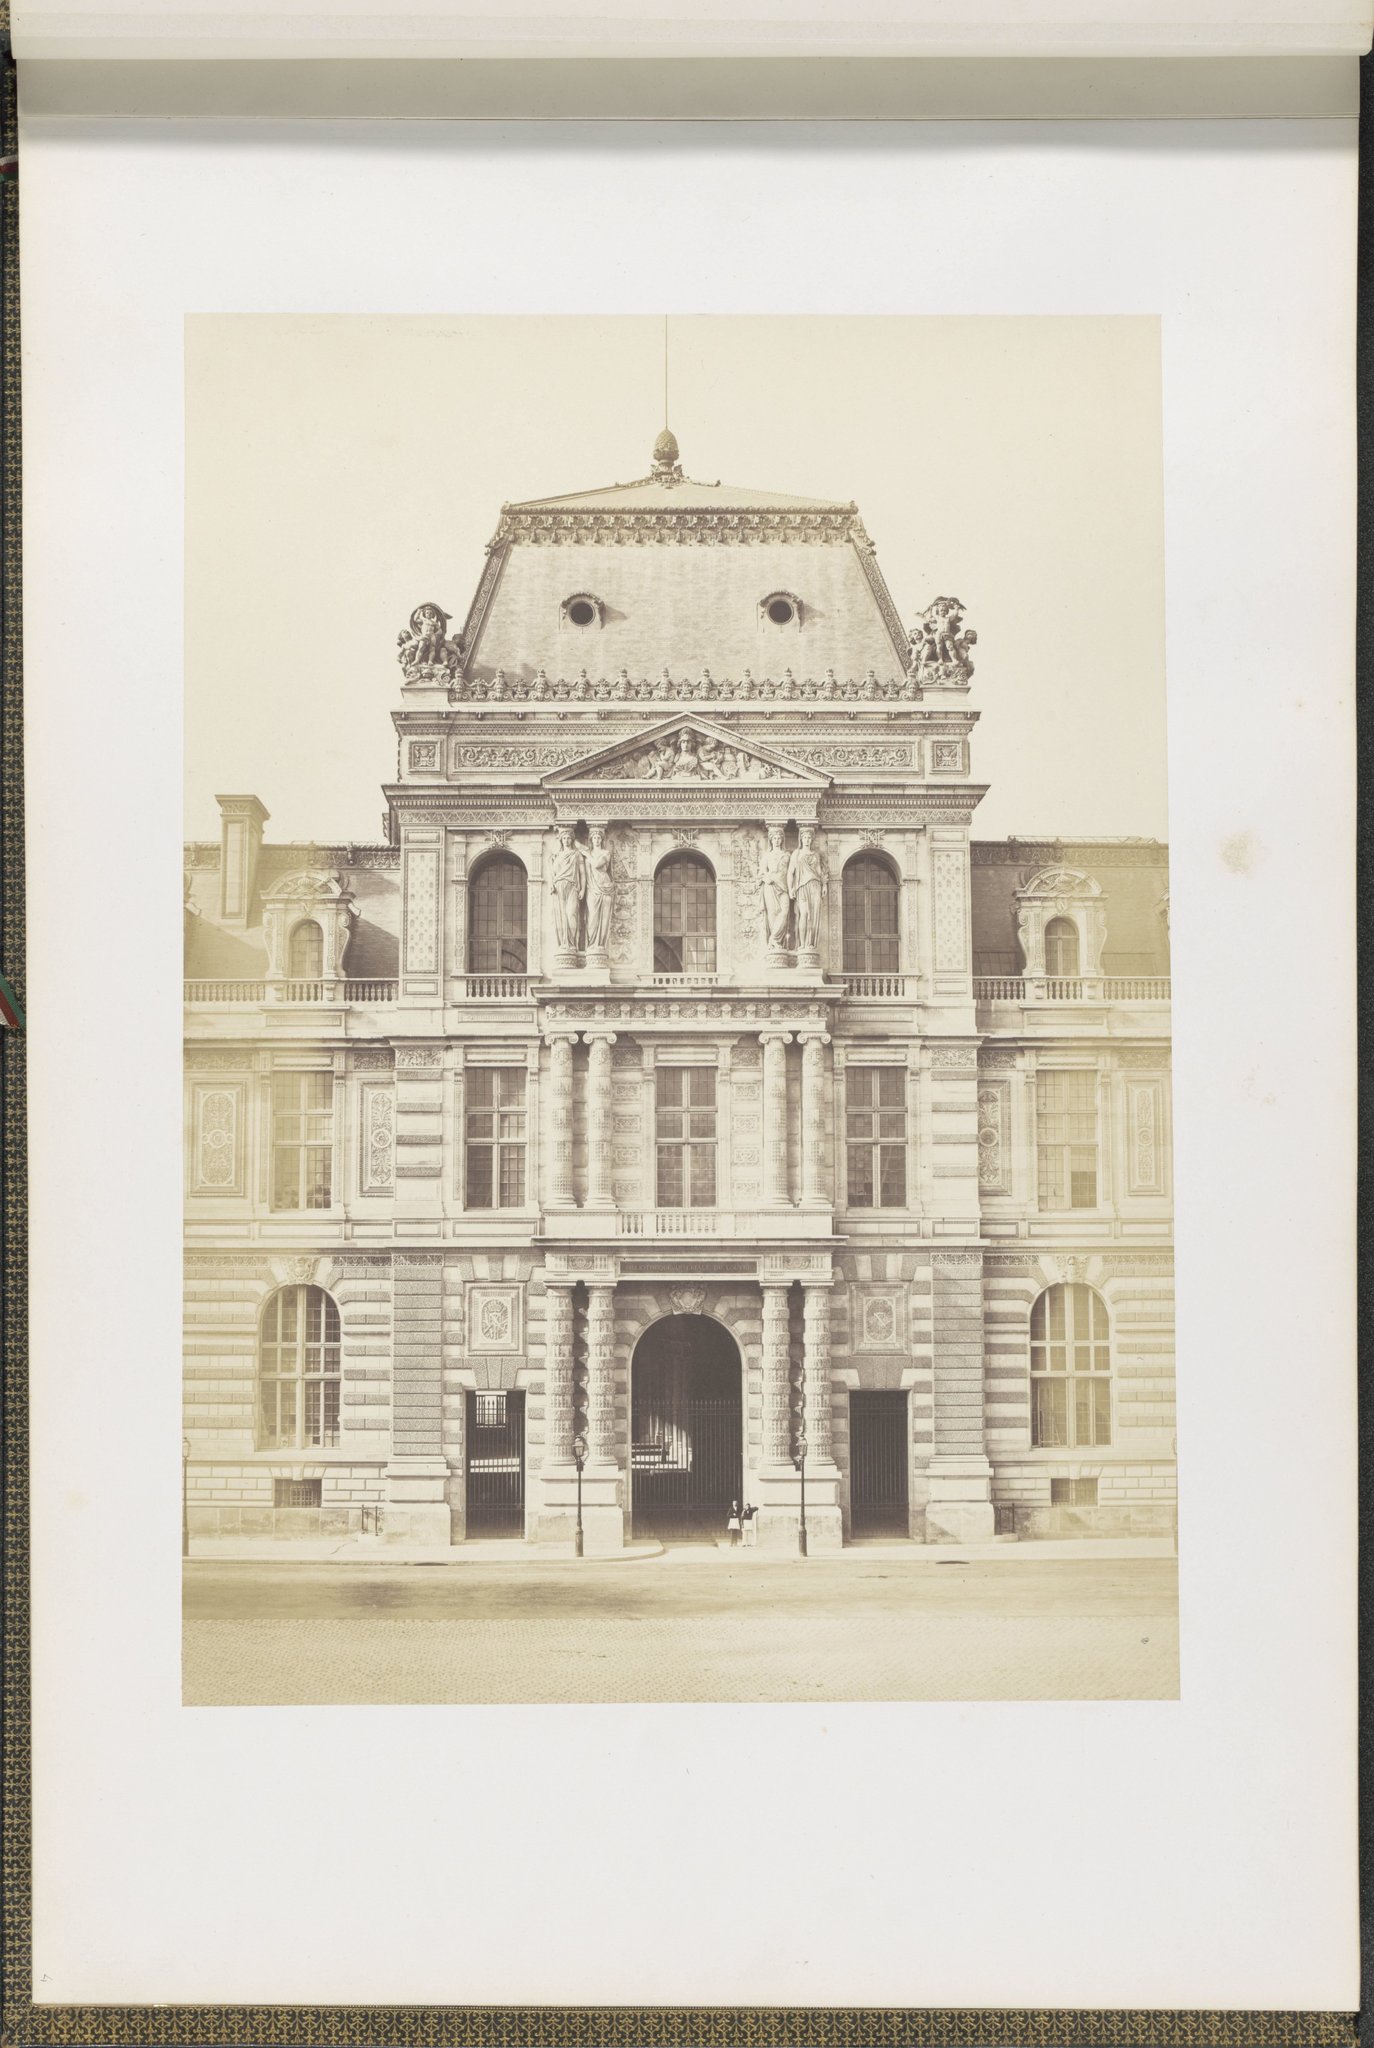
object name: album leaf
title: Gevel van de Bibliothèque Impériale in het Palais du Louvre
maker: édouard denis baldus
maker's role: fotograaf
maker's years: 1813-1889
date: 1857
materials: paper, photographic support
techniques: salted paper print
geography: paris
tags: permanent exhibition, museum, façade (of house or building), public library, paris, tuileries palace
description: Onderdeel van Réunion des Tuileries au Louvre 1852-1857, album 4.